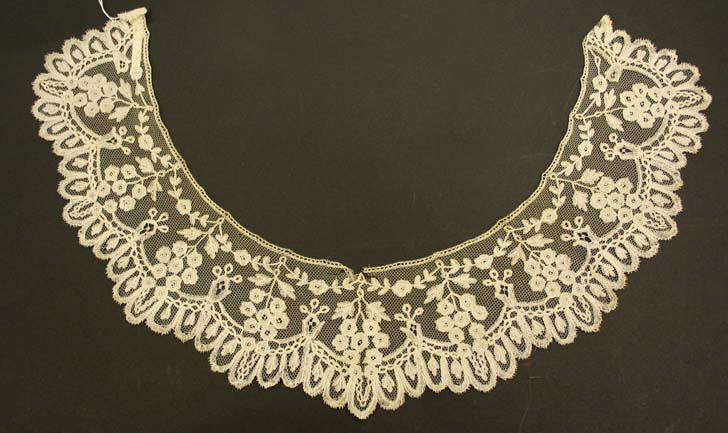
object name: collar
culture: american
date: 1700-1941